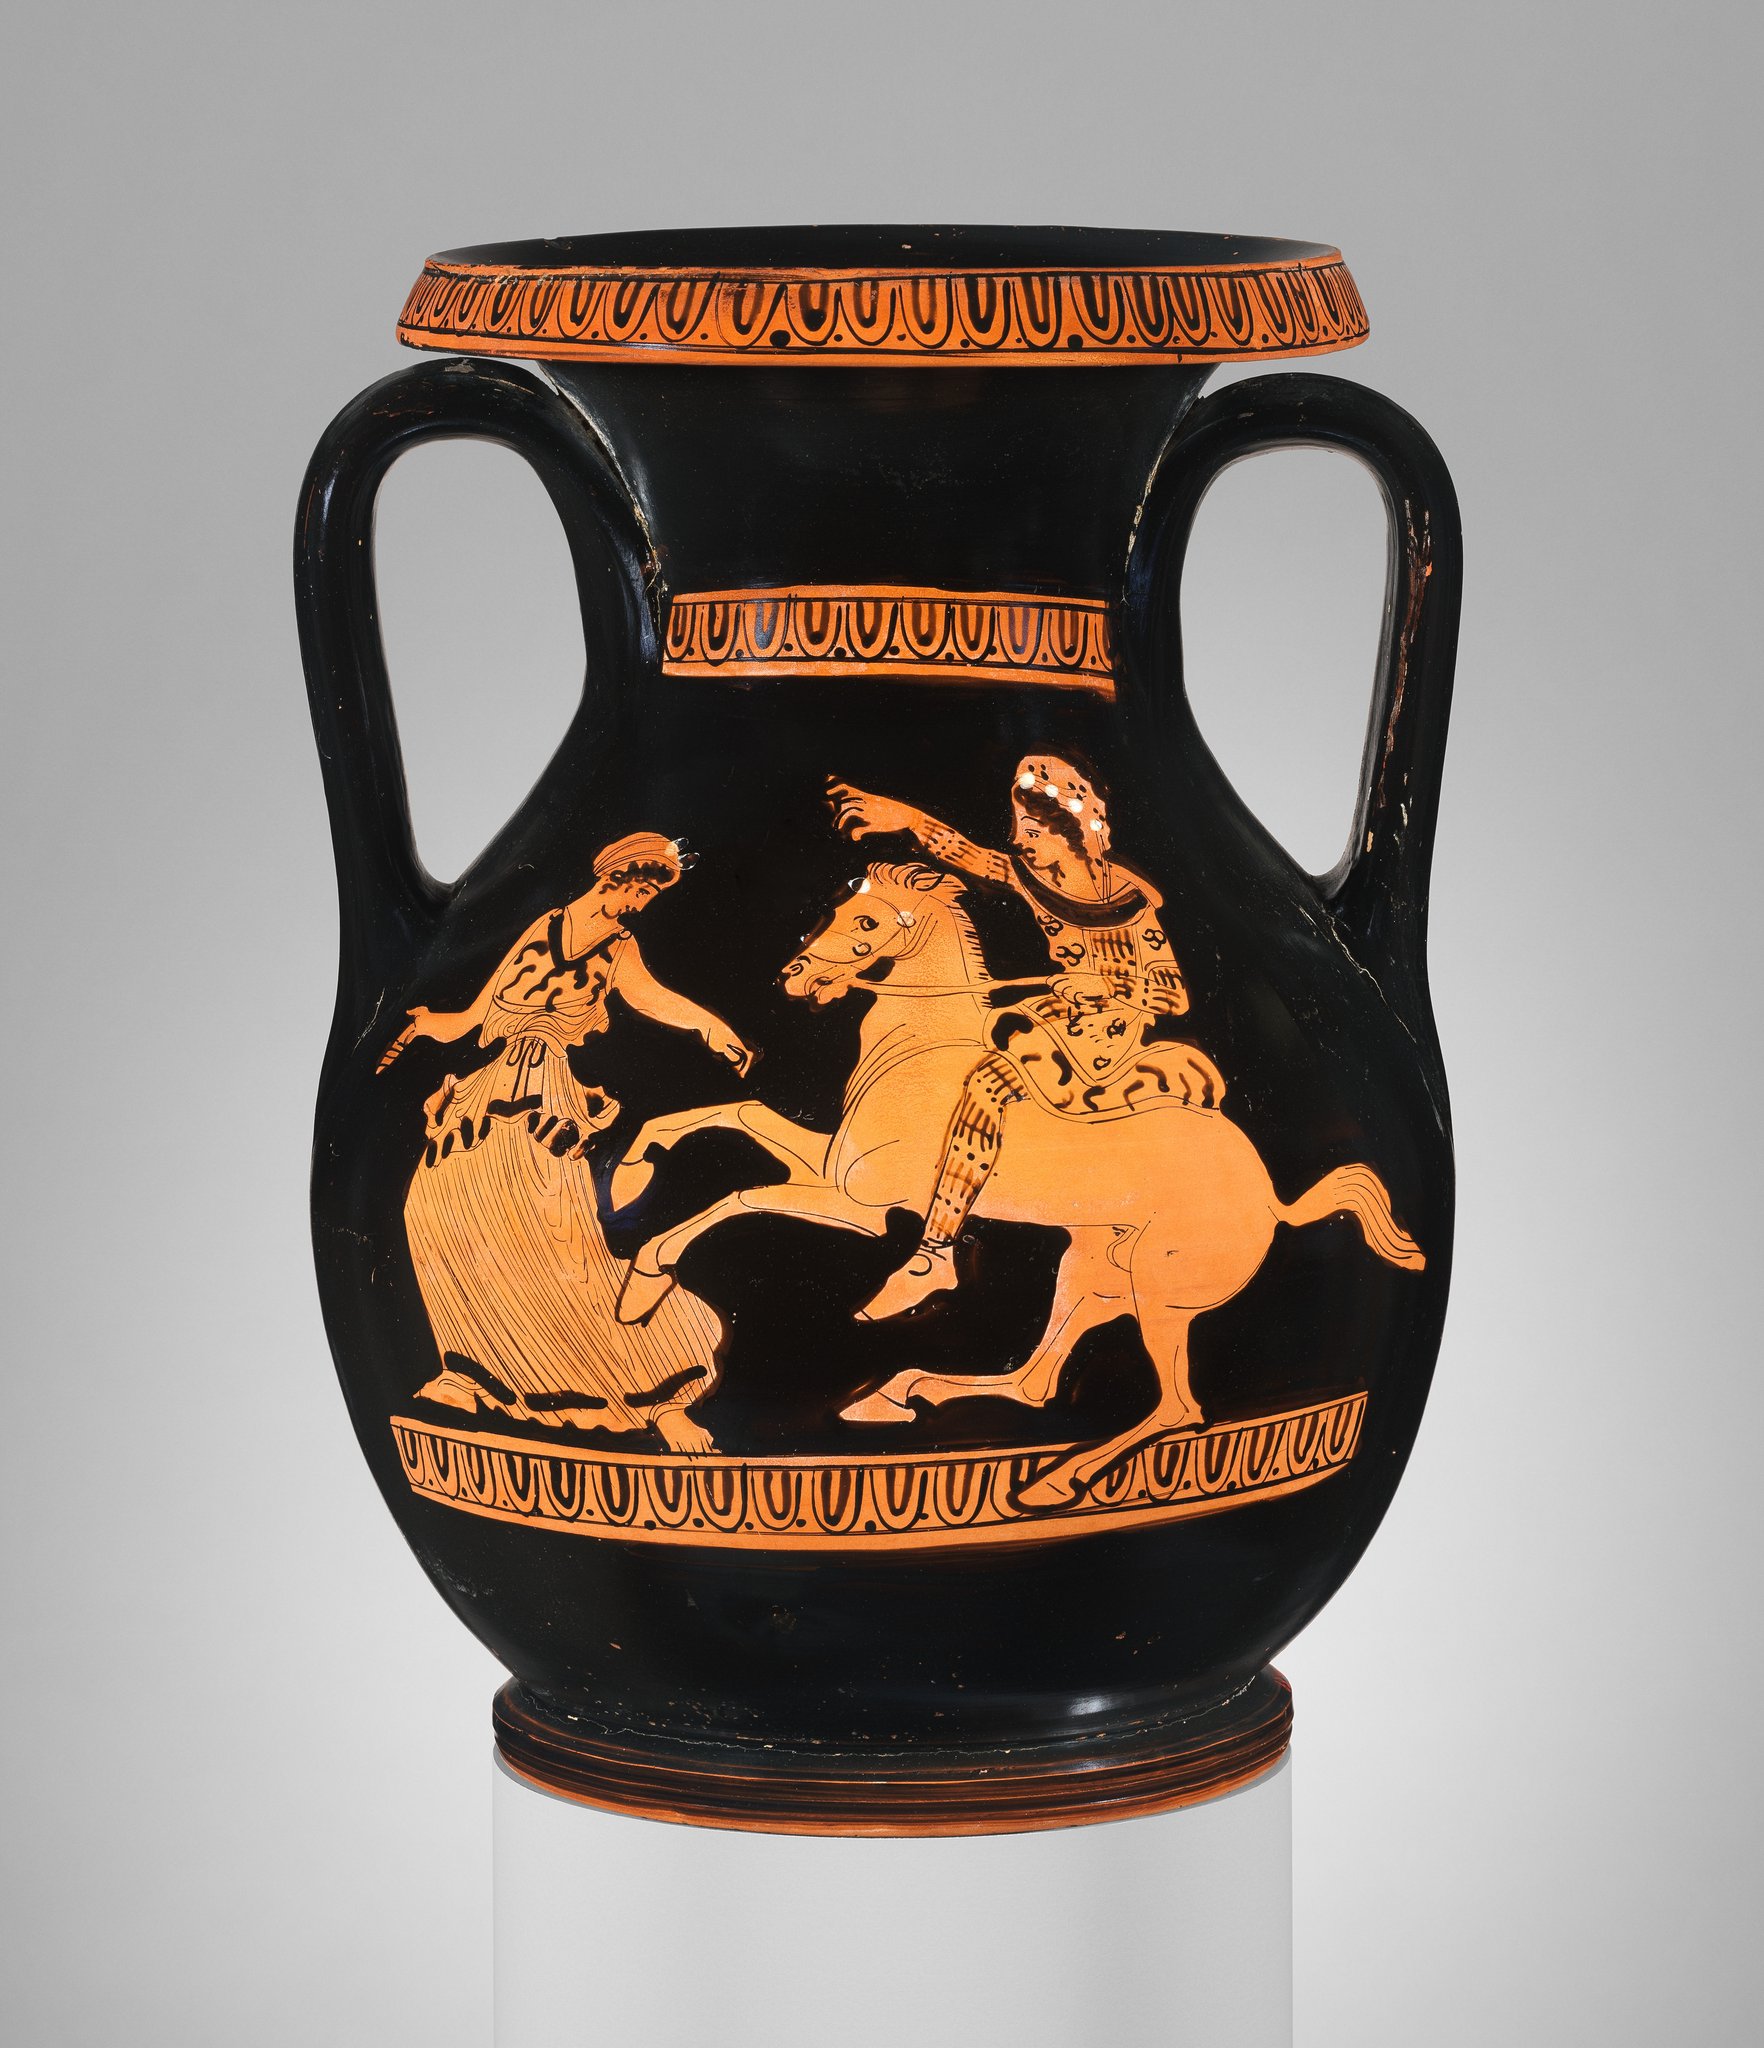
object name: pelike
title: Terracotta pelike (wine jar)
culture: greek, attic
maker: helbig-reverse group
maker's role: artist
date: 400-368 BCE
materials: terracotta